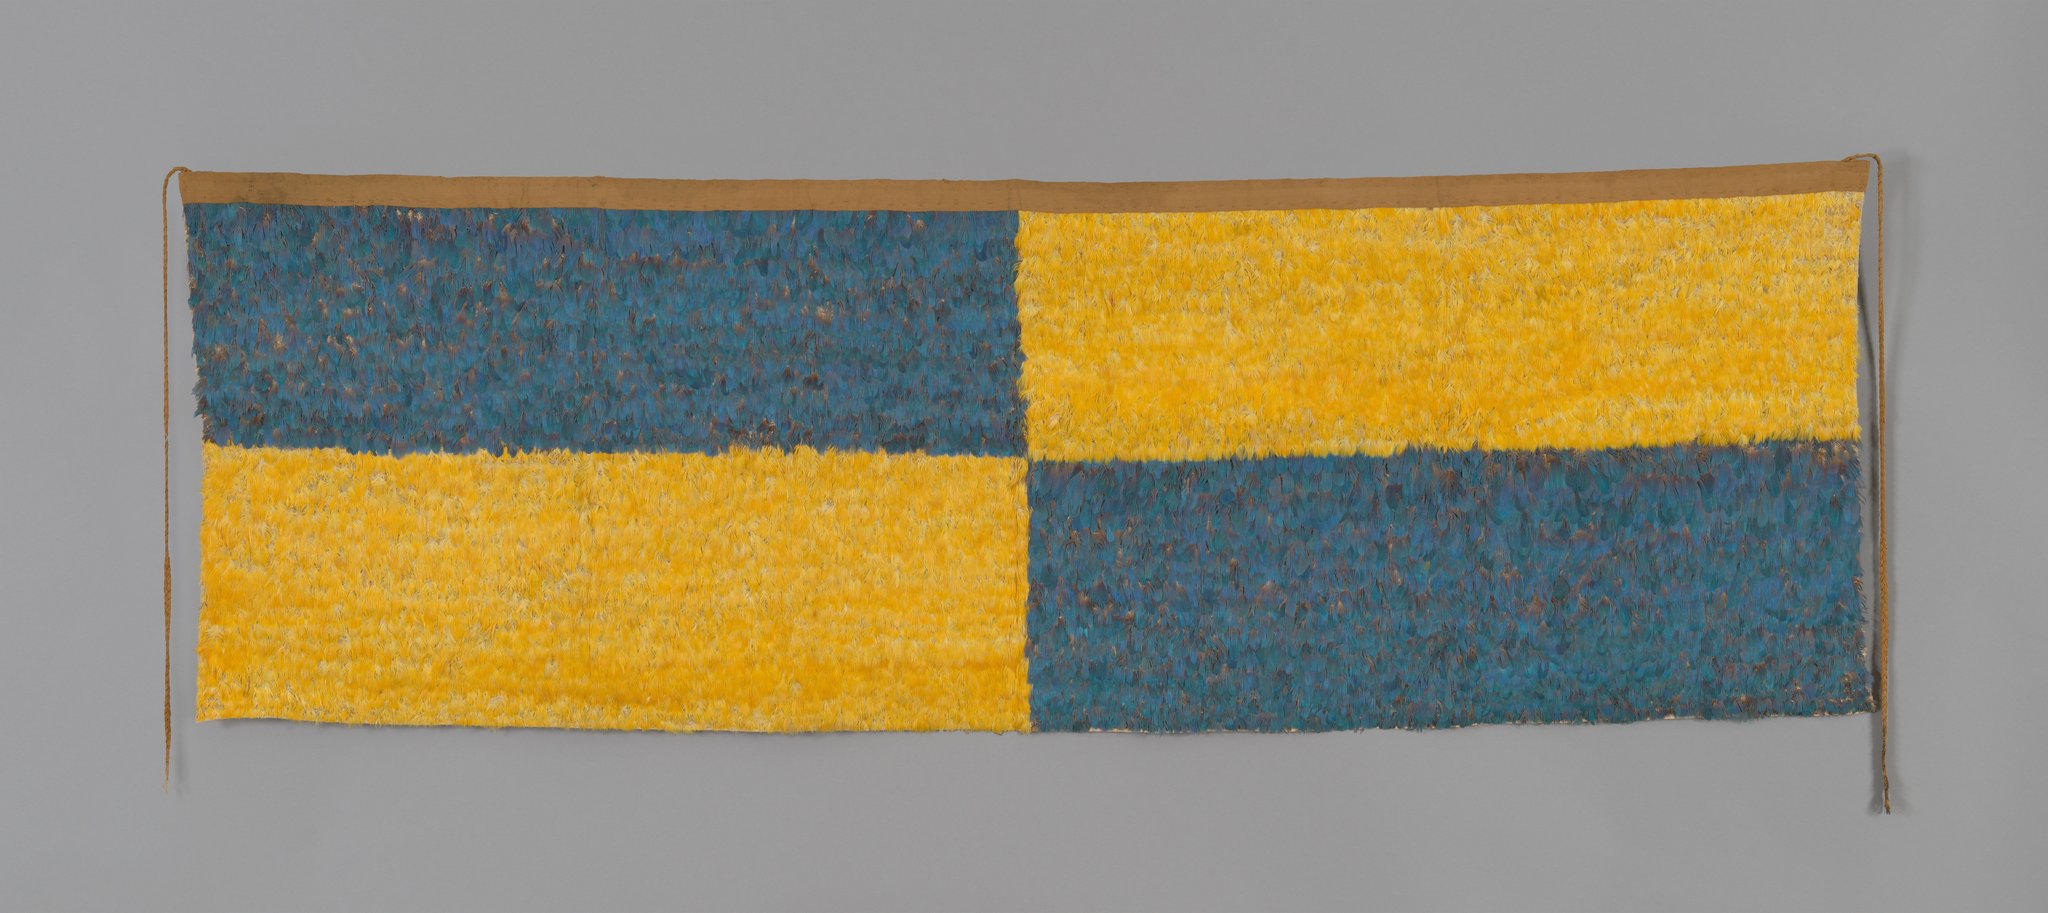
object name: panel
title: Feathered Panel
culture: wari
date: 600-900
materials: animal fiber, cotton, feather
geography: peru